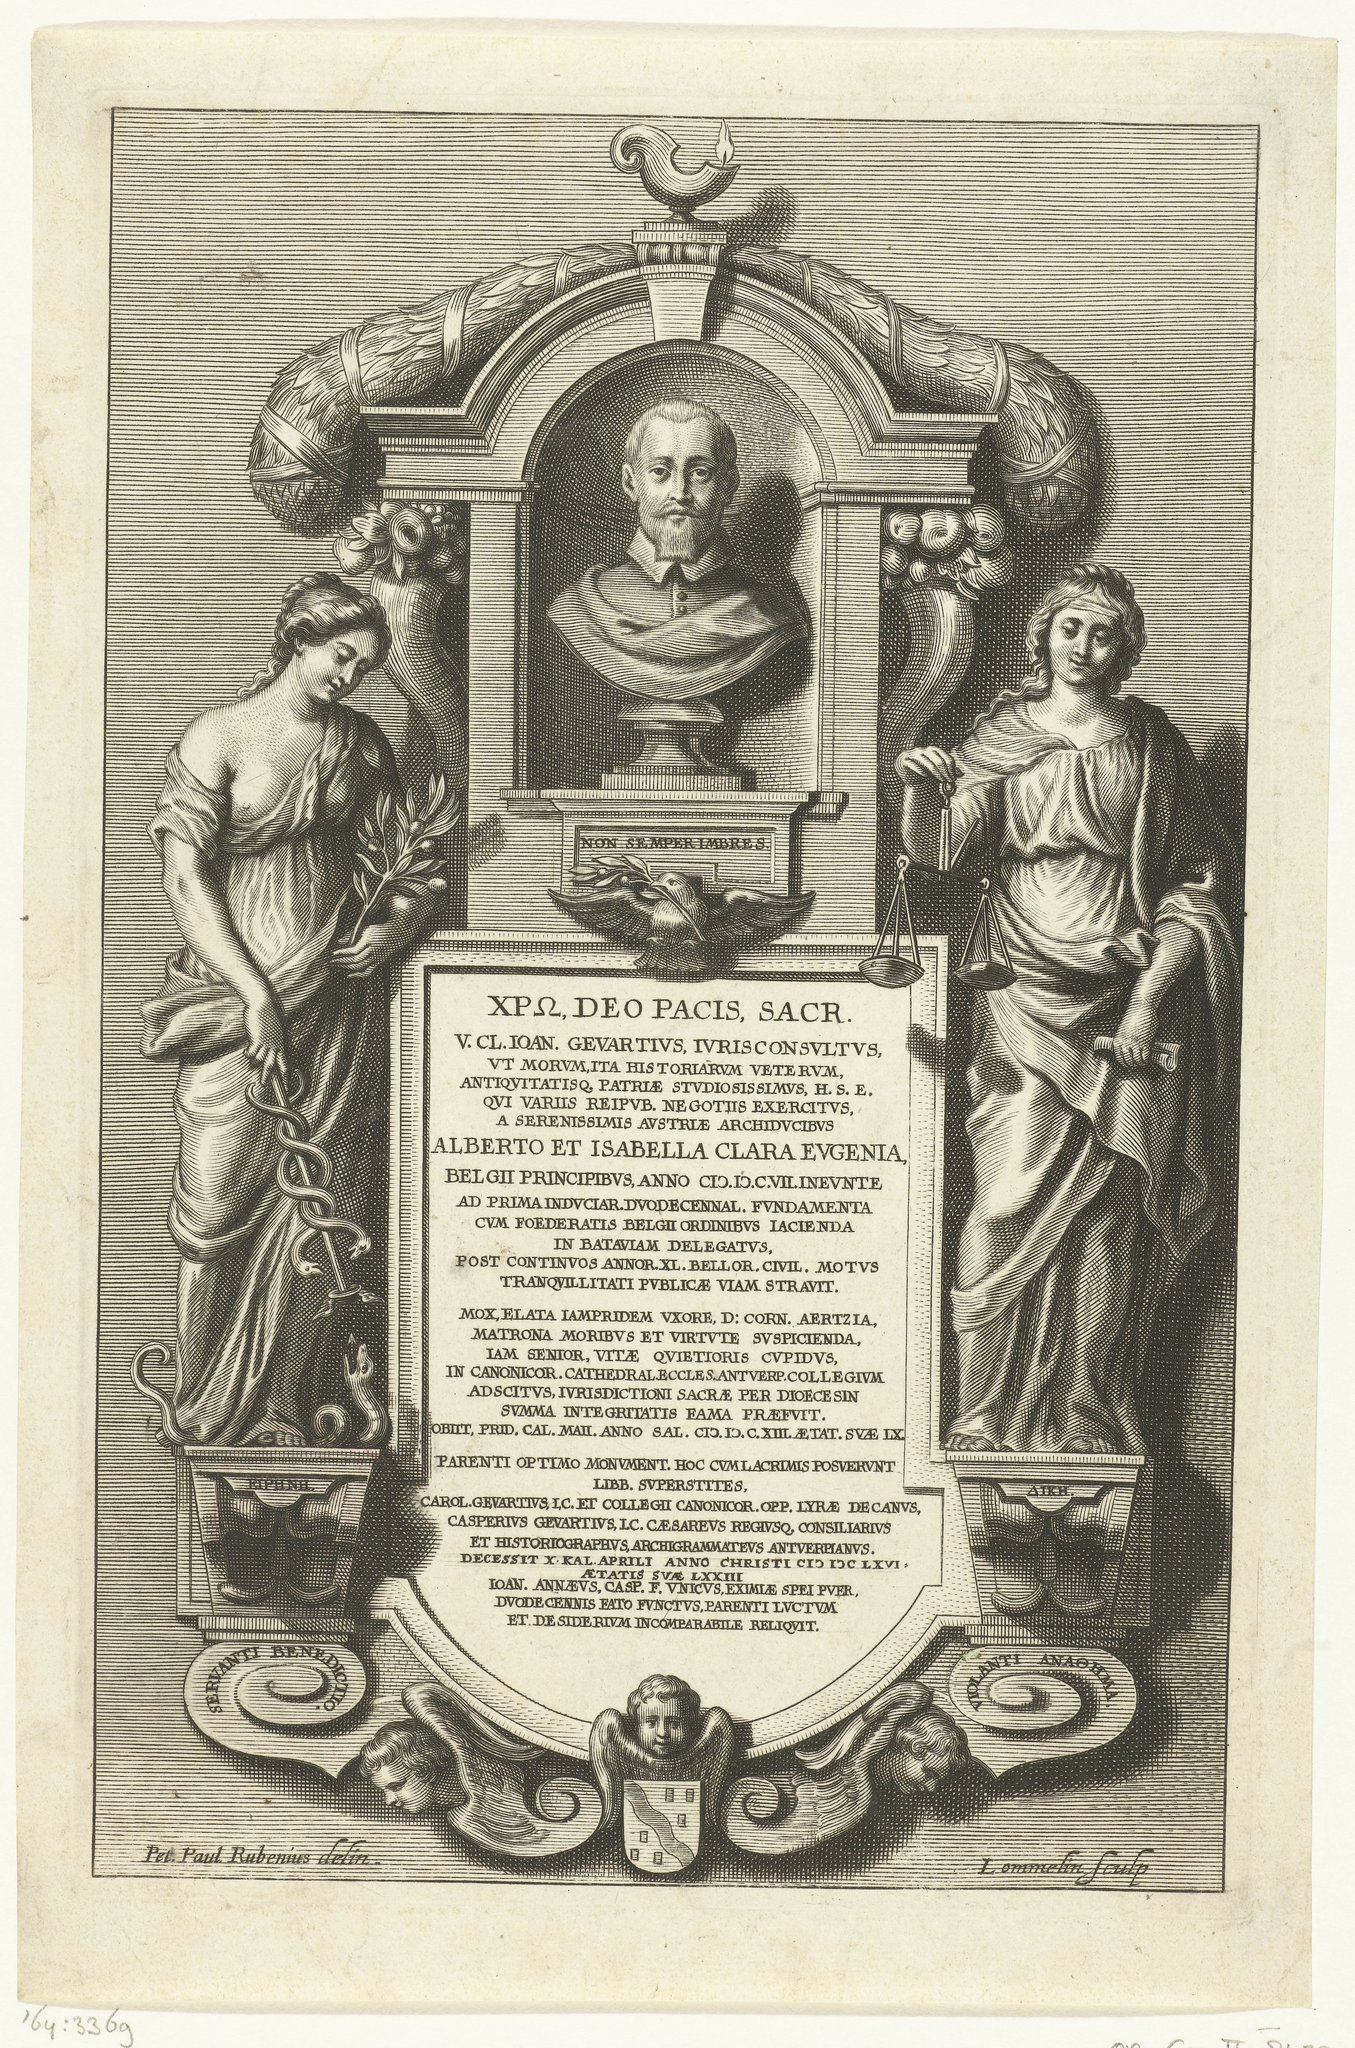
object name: ornament print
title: Epitaaf voor Albert en Isabella Clara Eugenia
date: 1666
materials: paper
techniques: engraving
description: Boven de herdenkingsplaat met Latijnse inscriptie staat een portretbuste in een nis met aan beide kanten een vrouw: links de personificatie van Vrede, rechts Justitia.